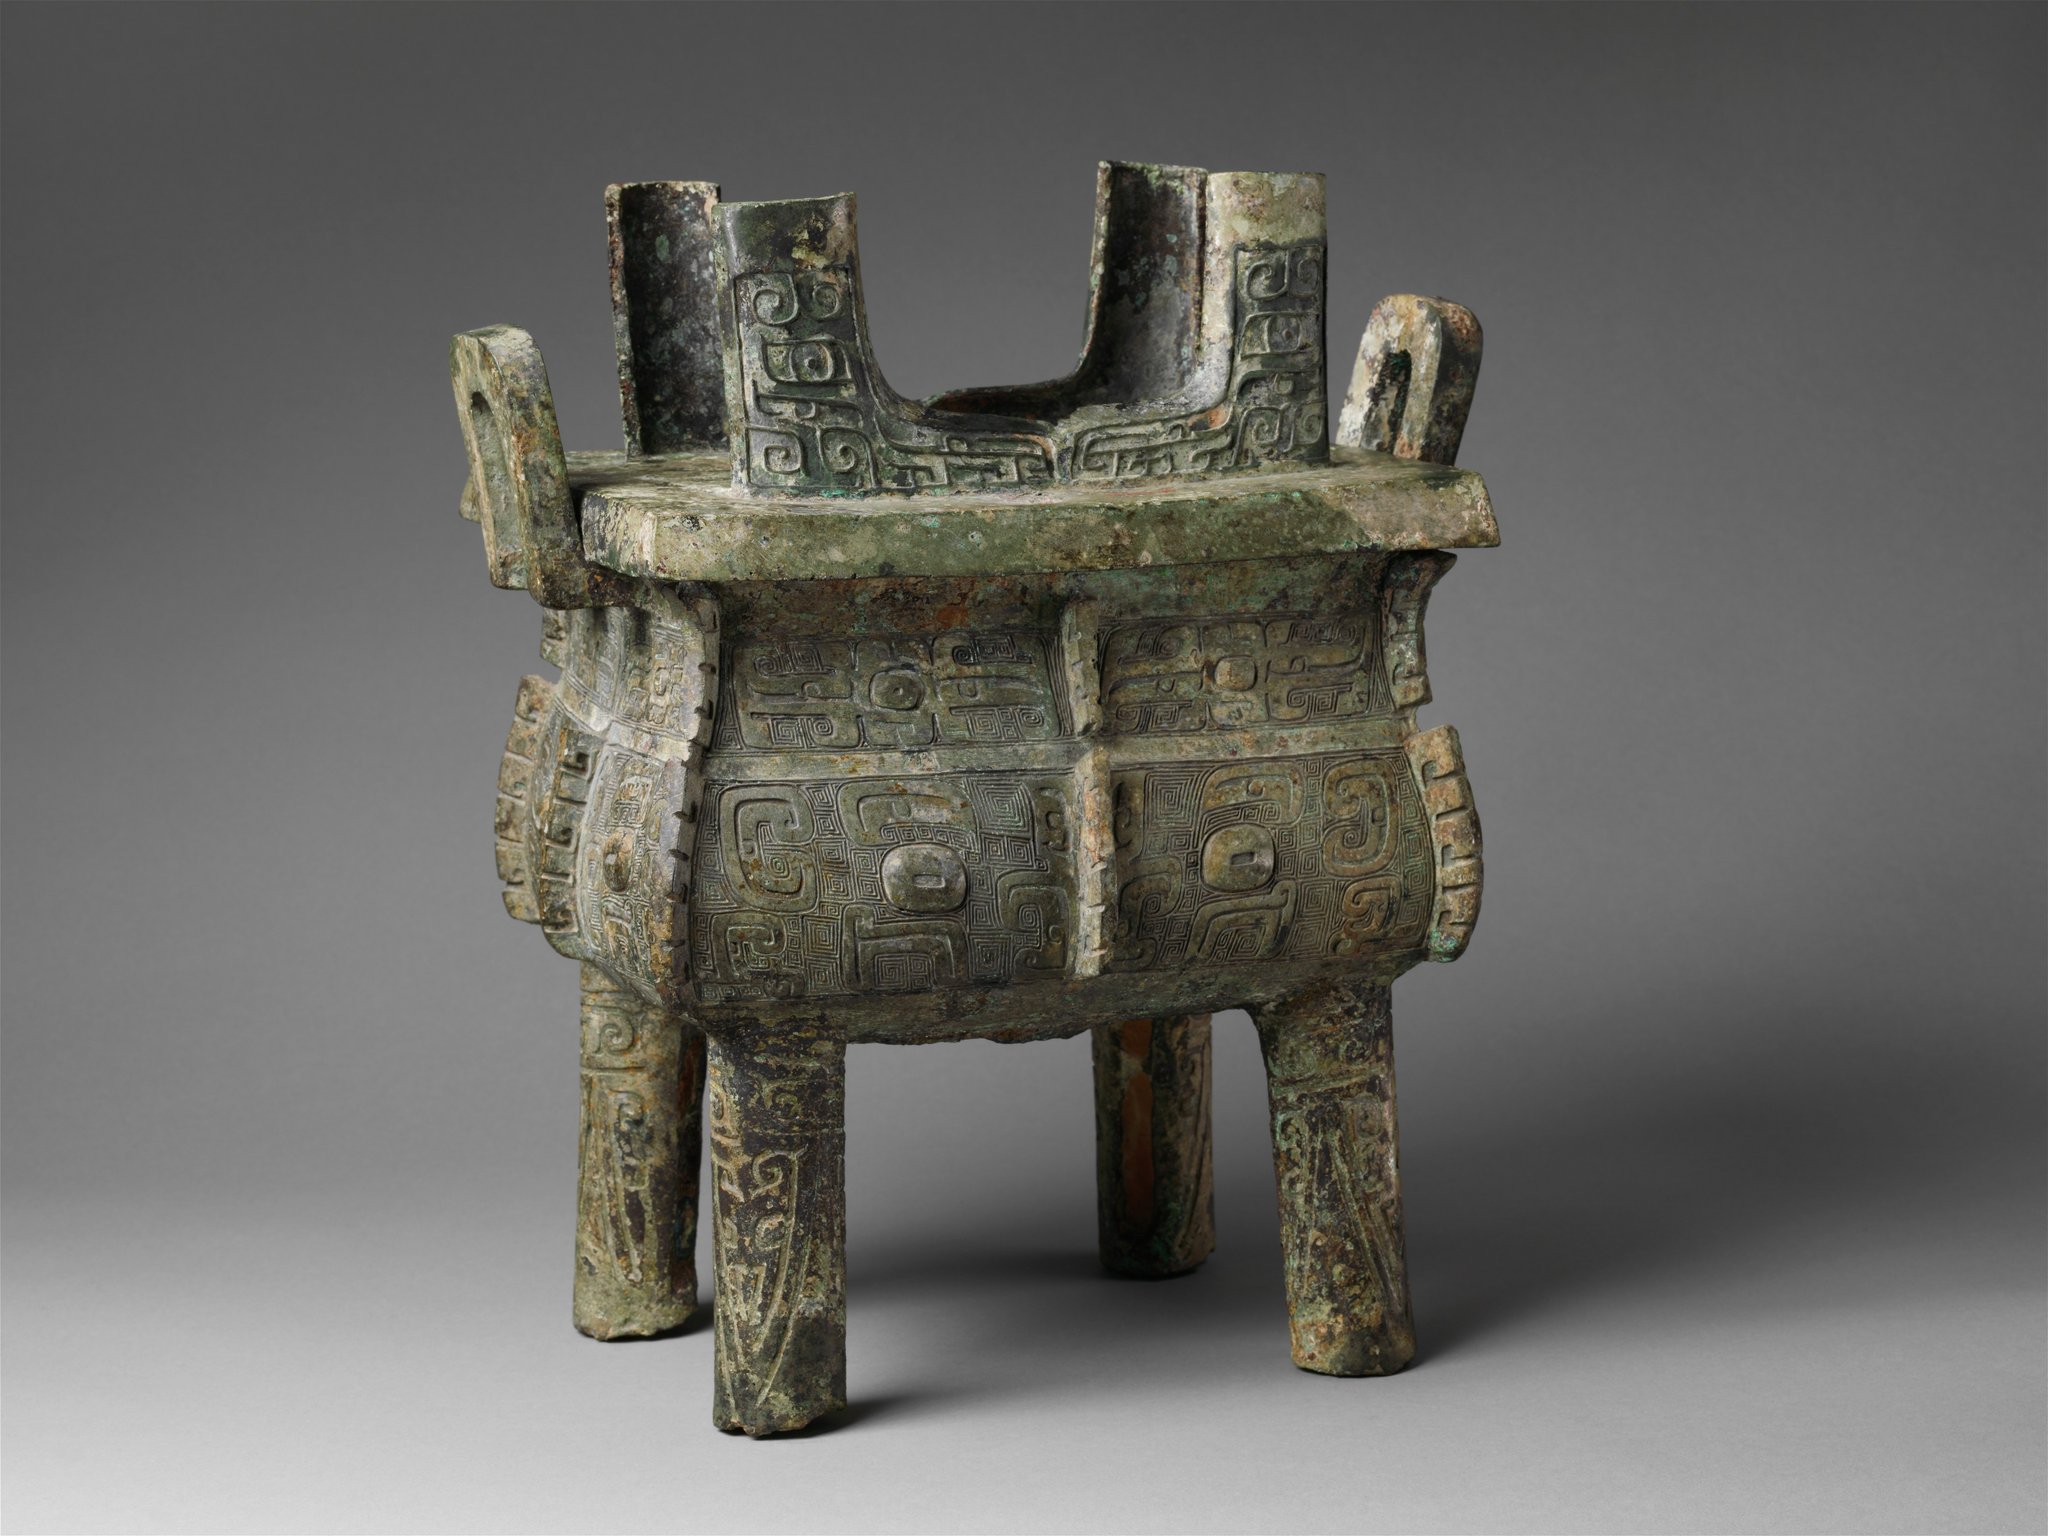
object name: cauldron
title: Rectangular cauldron (Fangding) with footed cover (Zu)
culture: chinese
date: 1100-1001 BCE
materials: bronze, pigment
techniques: inlay